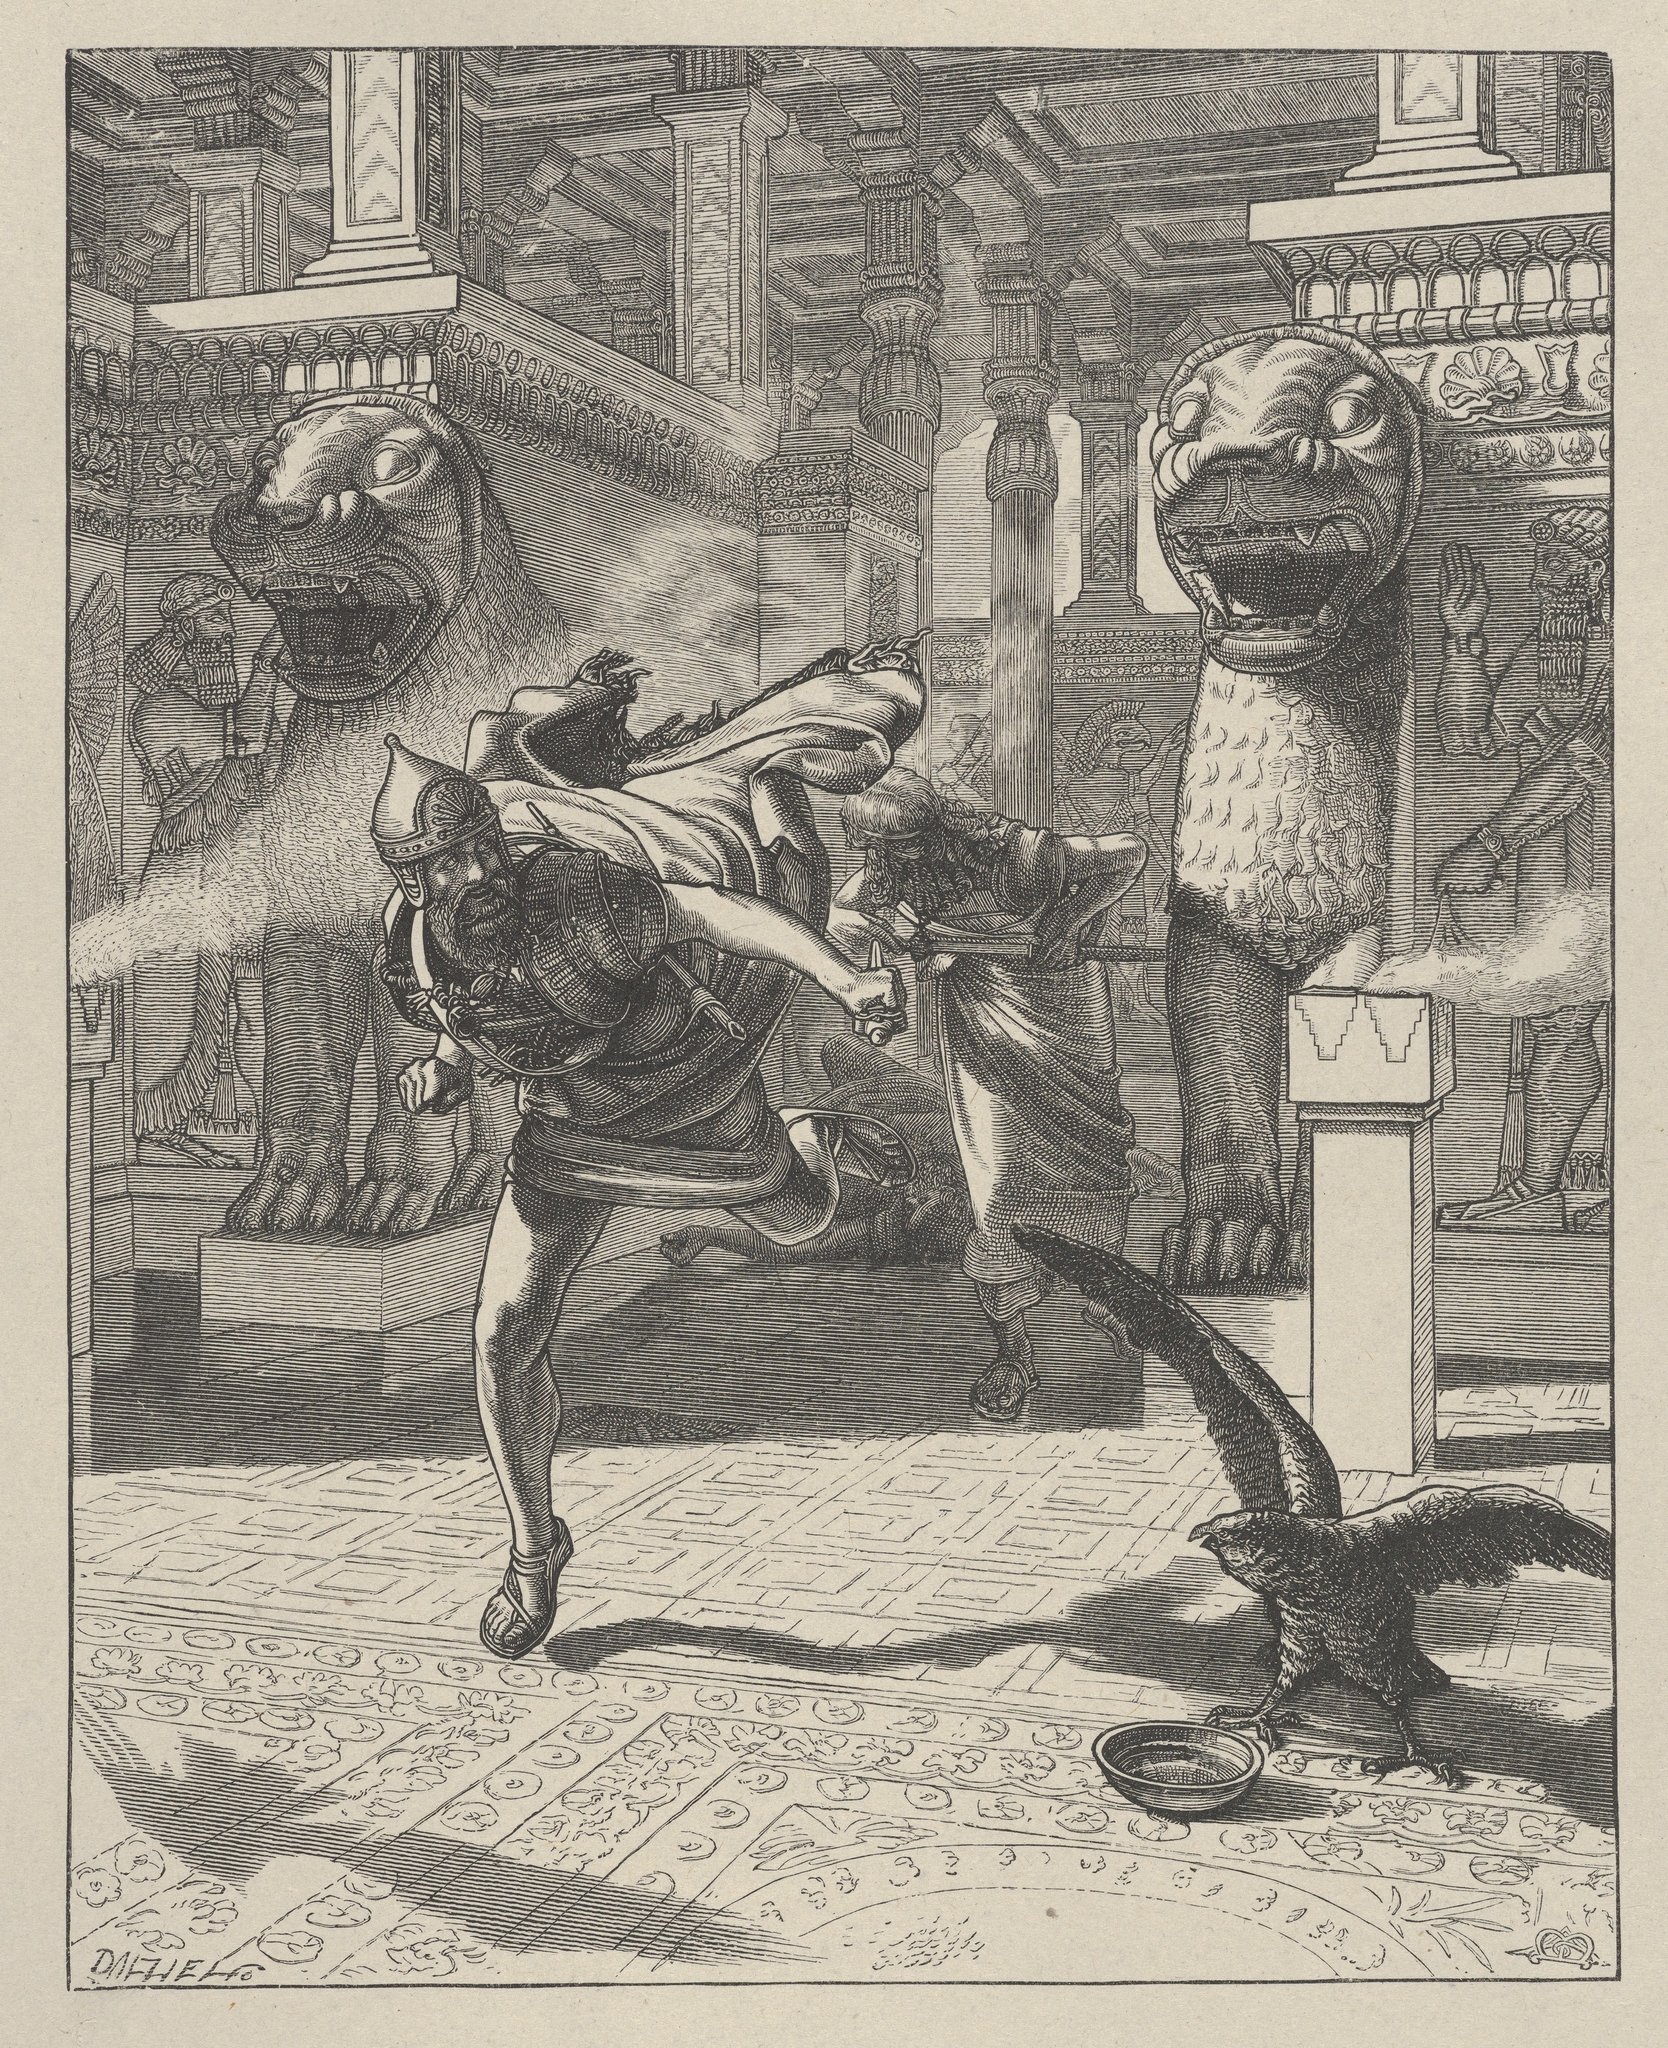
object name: print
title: The Flight of Adrammelech, from "Dalziels' Bible Gallery"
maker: arthur murch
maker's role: artist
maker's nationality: british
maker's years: 1836-1885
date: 1865-1881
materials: paper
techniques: engraving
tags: birds,soldiers,men